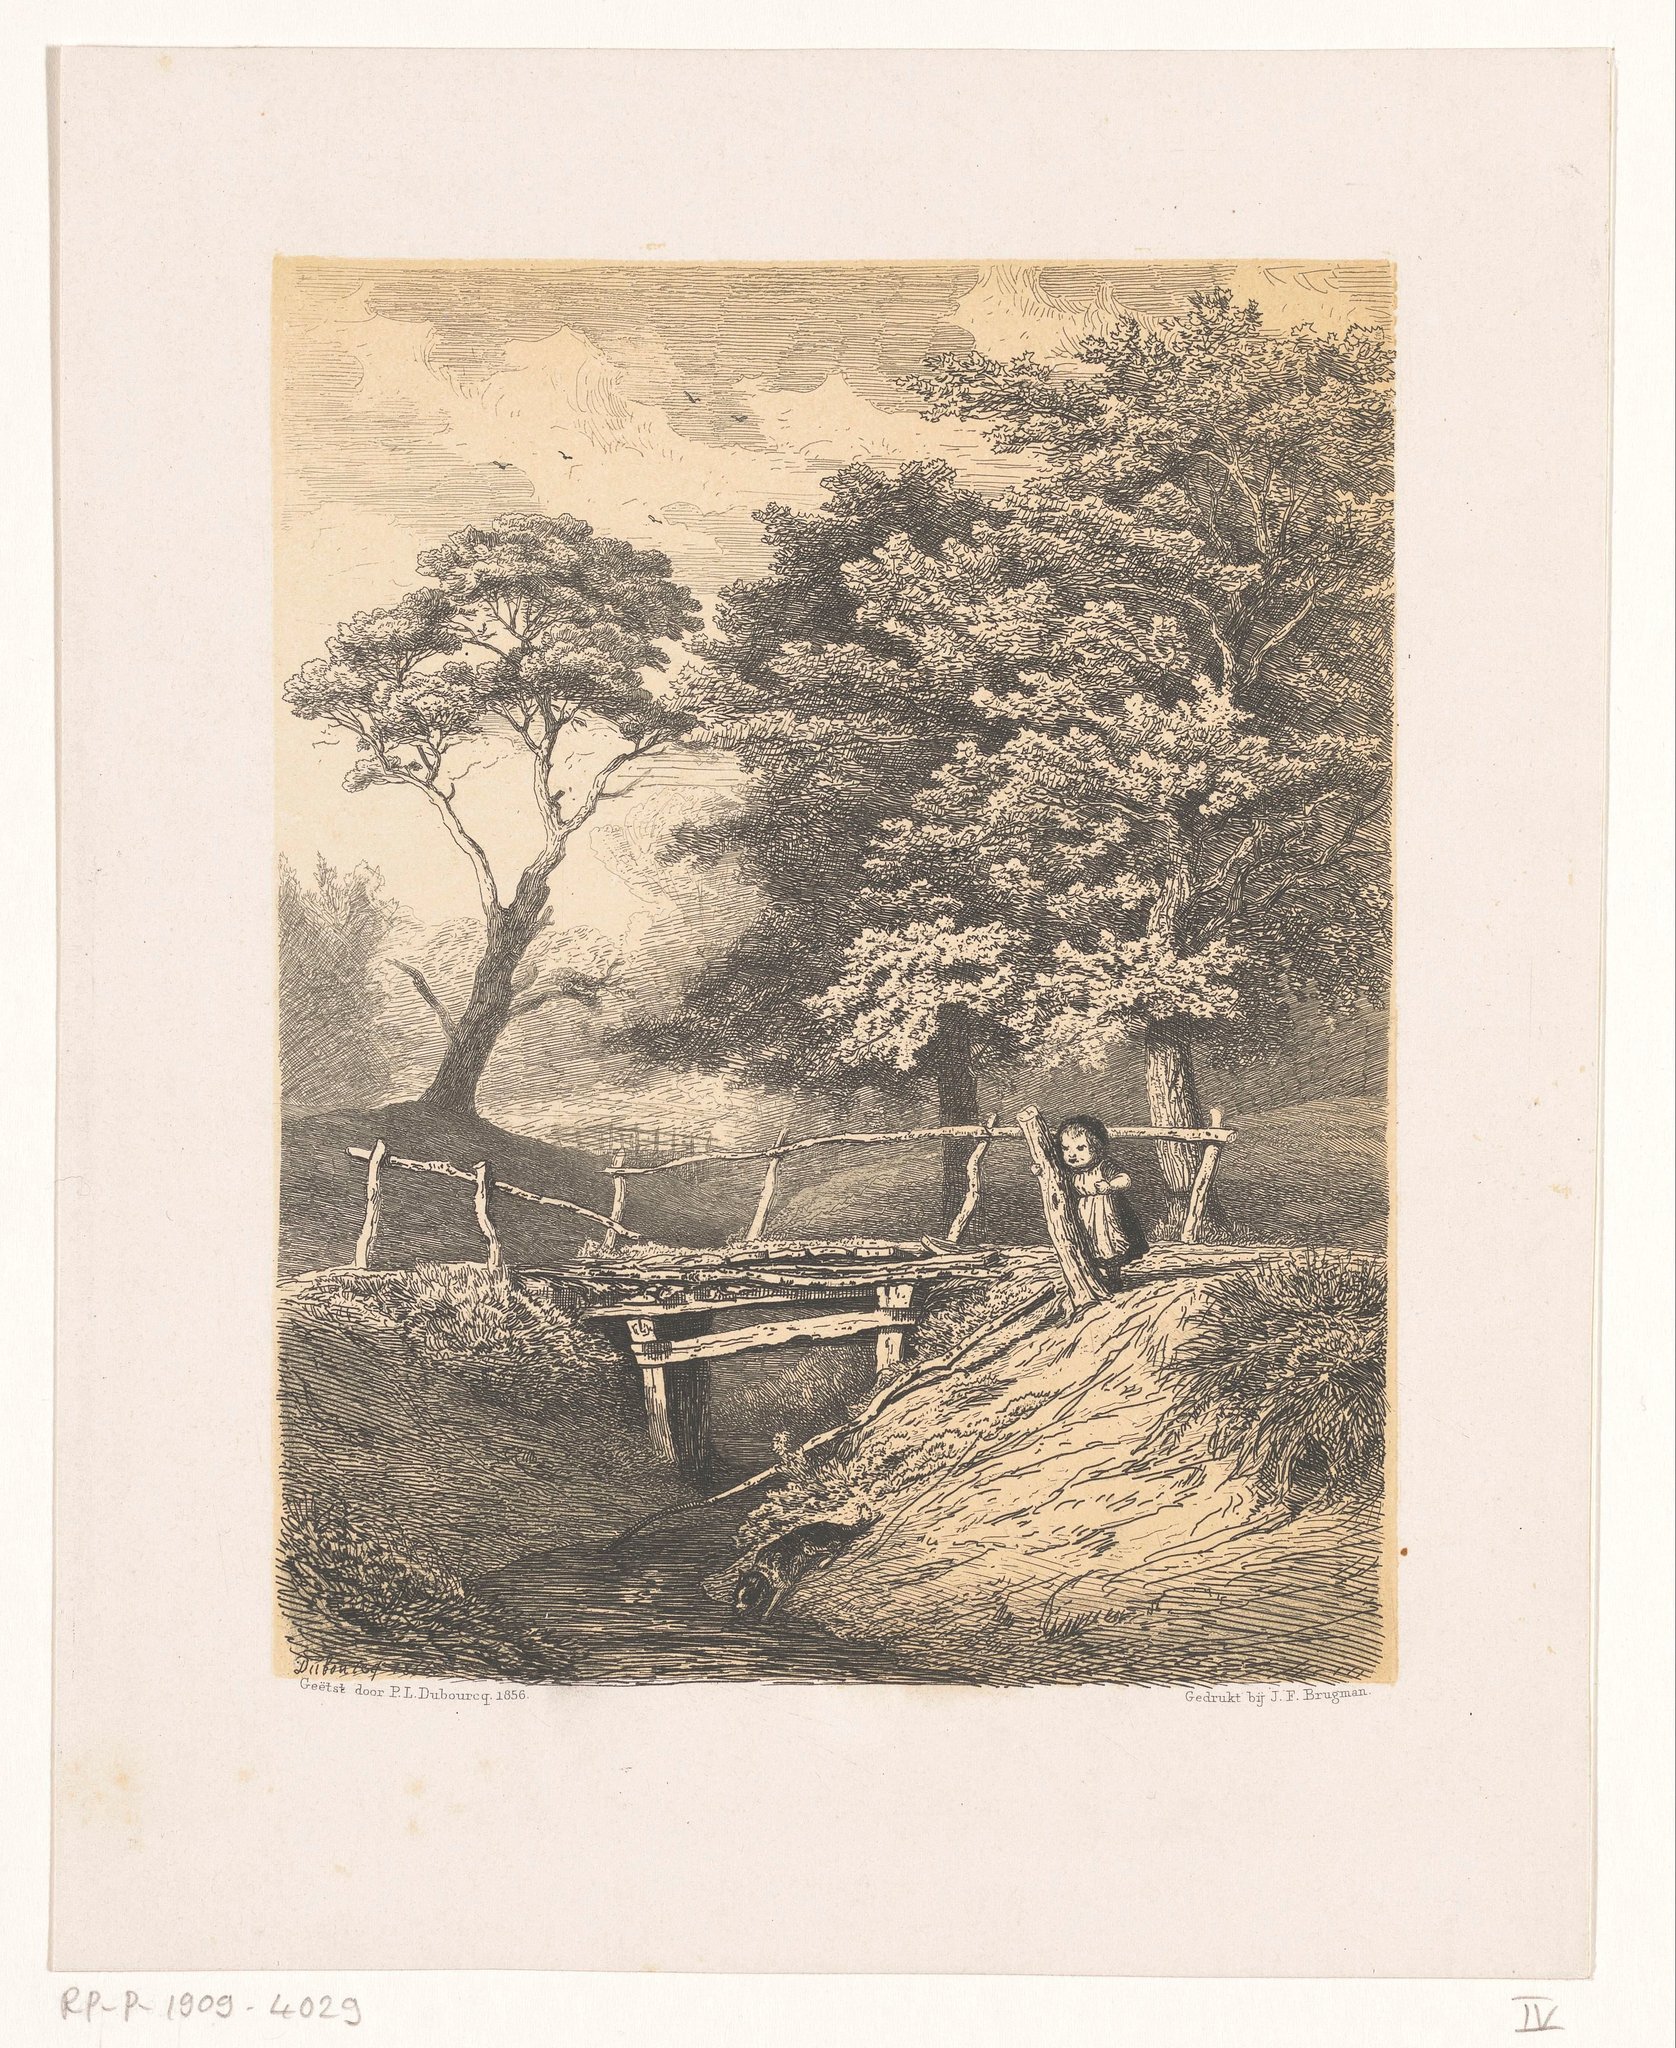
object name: print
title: Meisje met hond bij houten brug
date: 1856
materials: paper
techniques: drypoint, etching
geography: netherlands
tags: child playing with animals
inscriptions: collector's mark: Lugt 1485